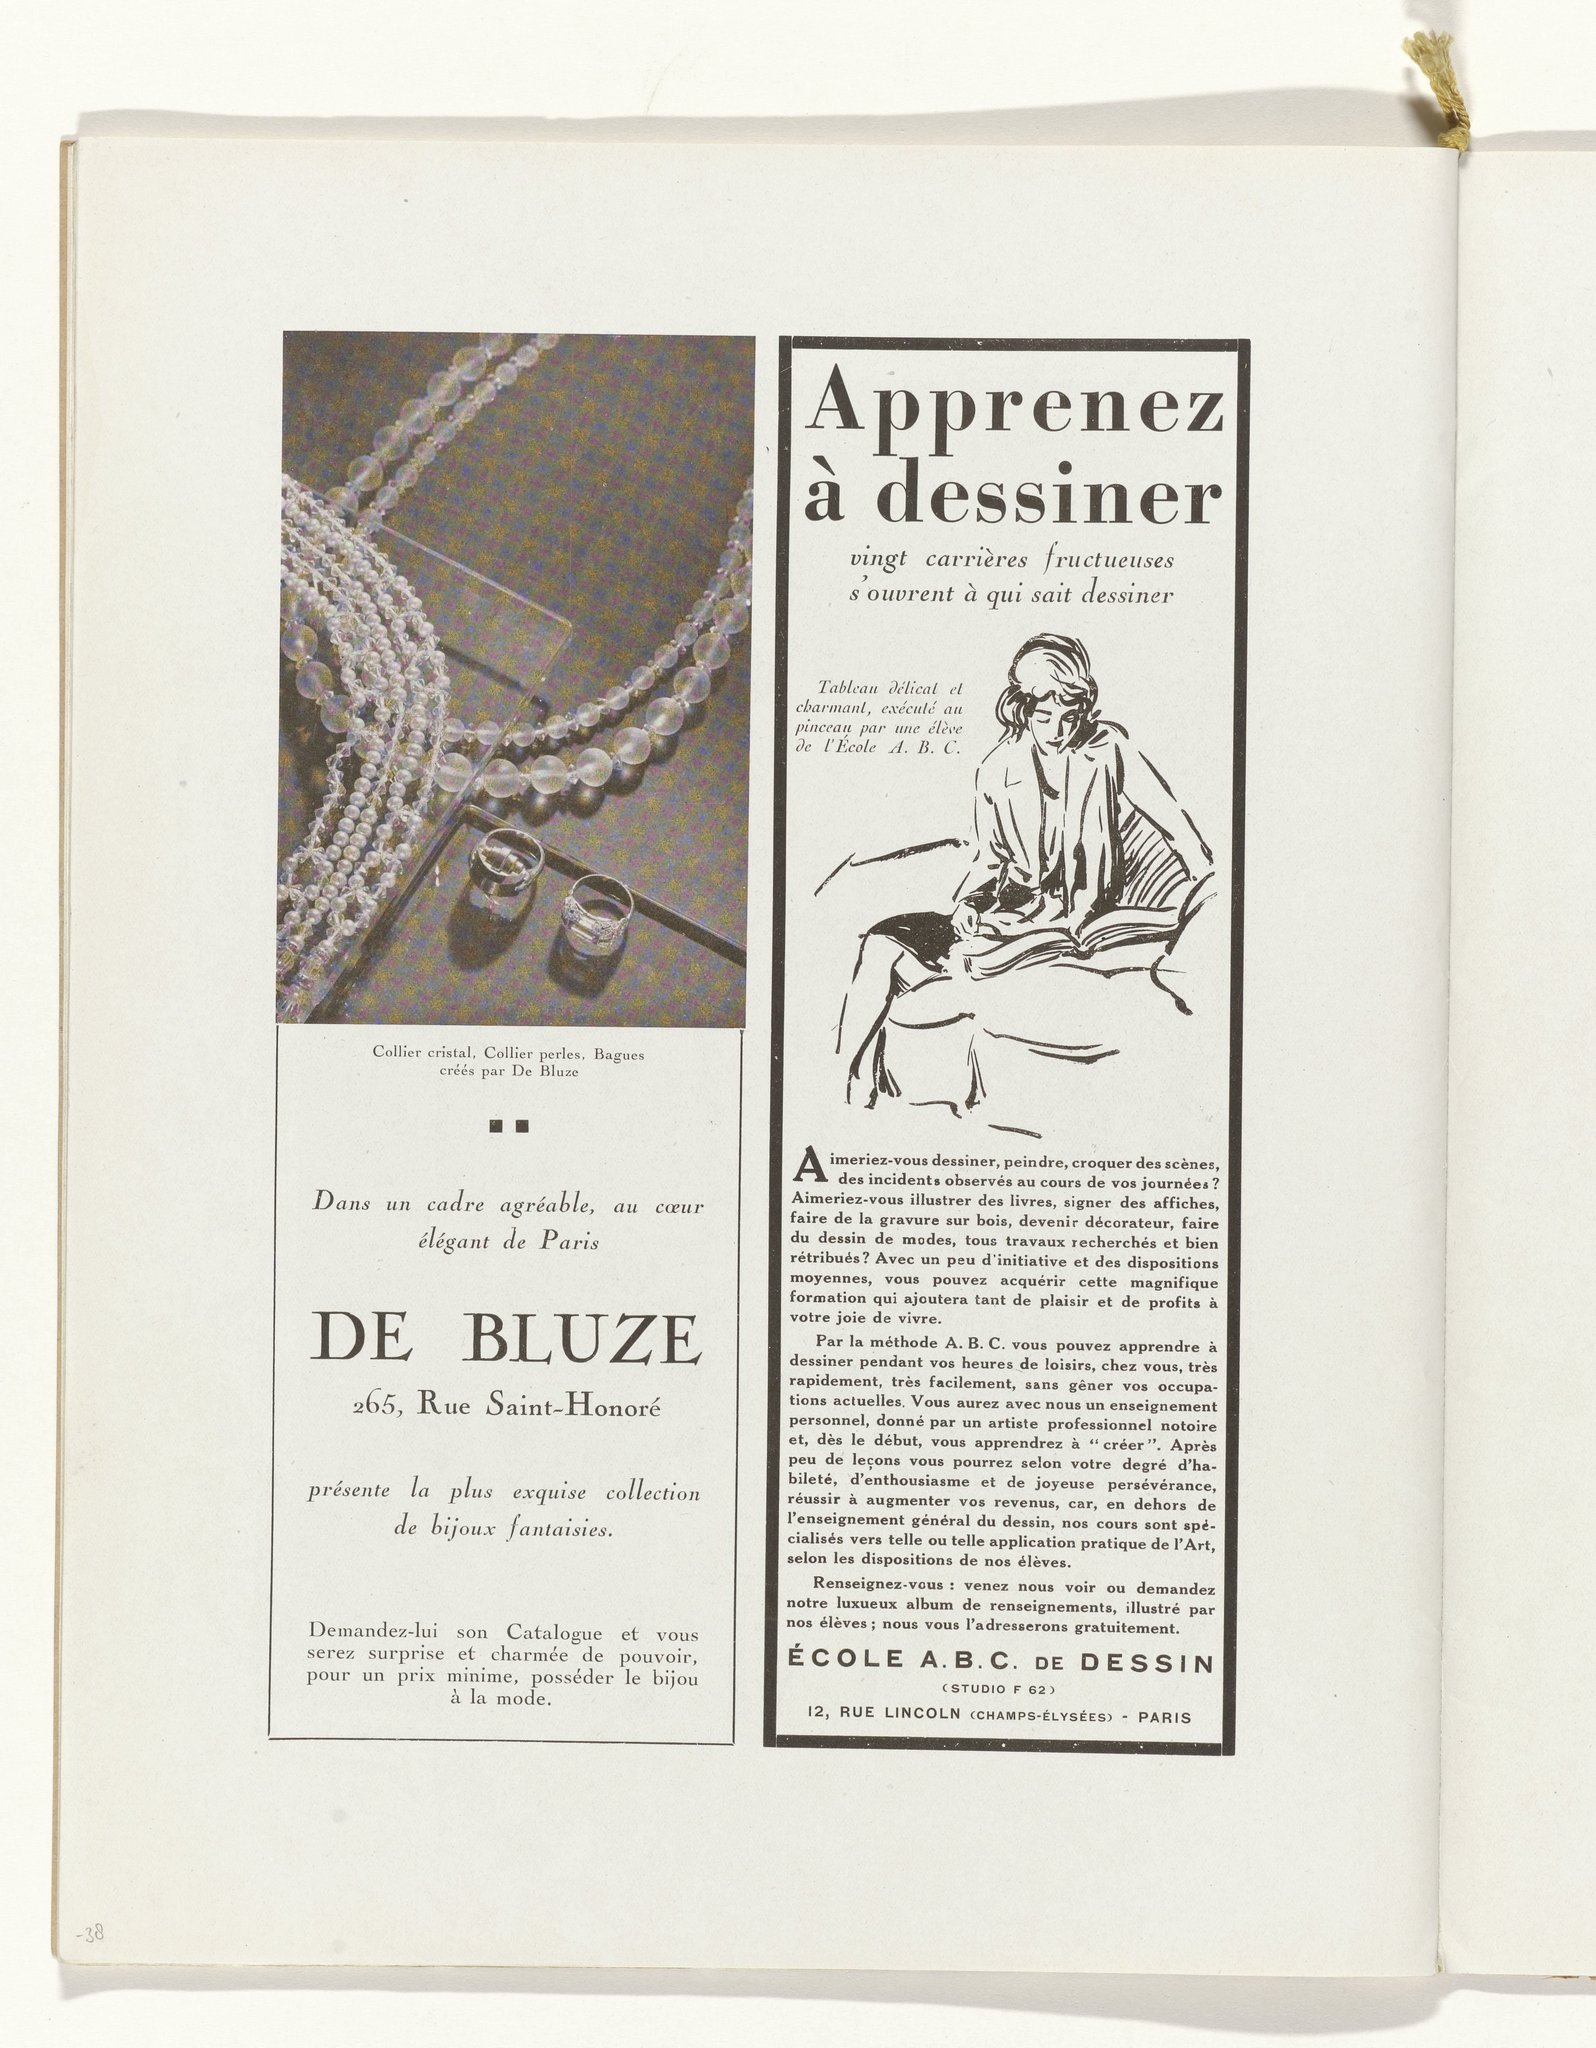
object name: magazine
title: Art - Goût - Beauté, Feuillets de l' élégance féminine, Novembre 1931, No. 135, 12e Année, p. 38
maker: charles goy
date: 1931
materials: paper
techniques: photography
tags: ring (+ women's clothes), fashion plates, pearl; pearl necklace (+ women's clothes)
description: Twee advertenties, waaronder één voor colliers en ringen van de juwelier De Bluze. Pagina uit het modetijdschrift Art-Goût-Beauté (1920-1933).